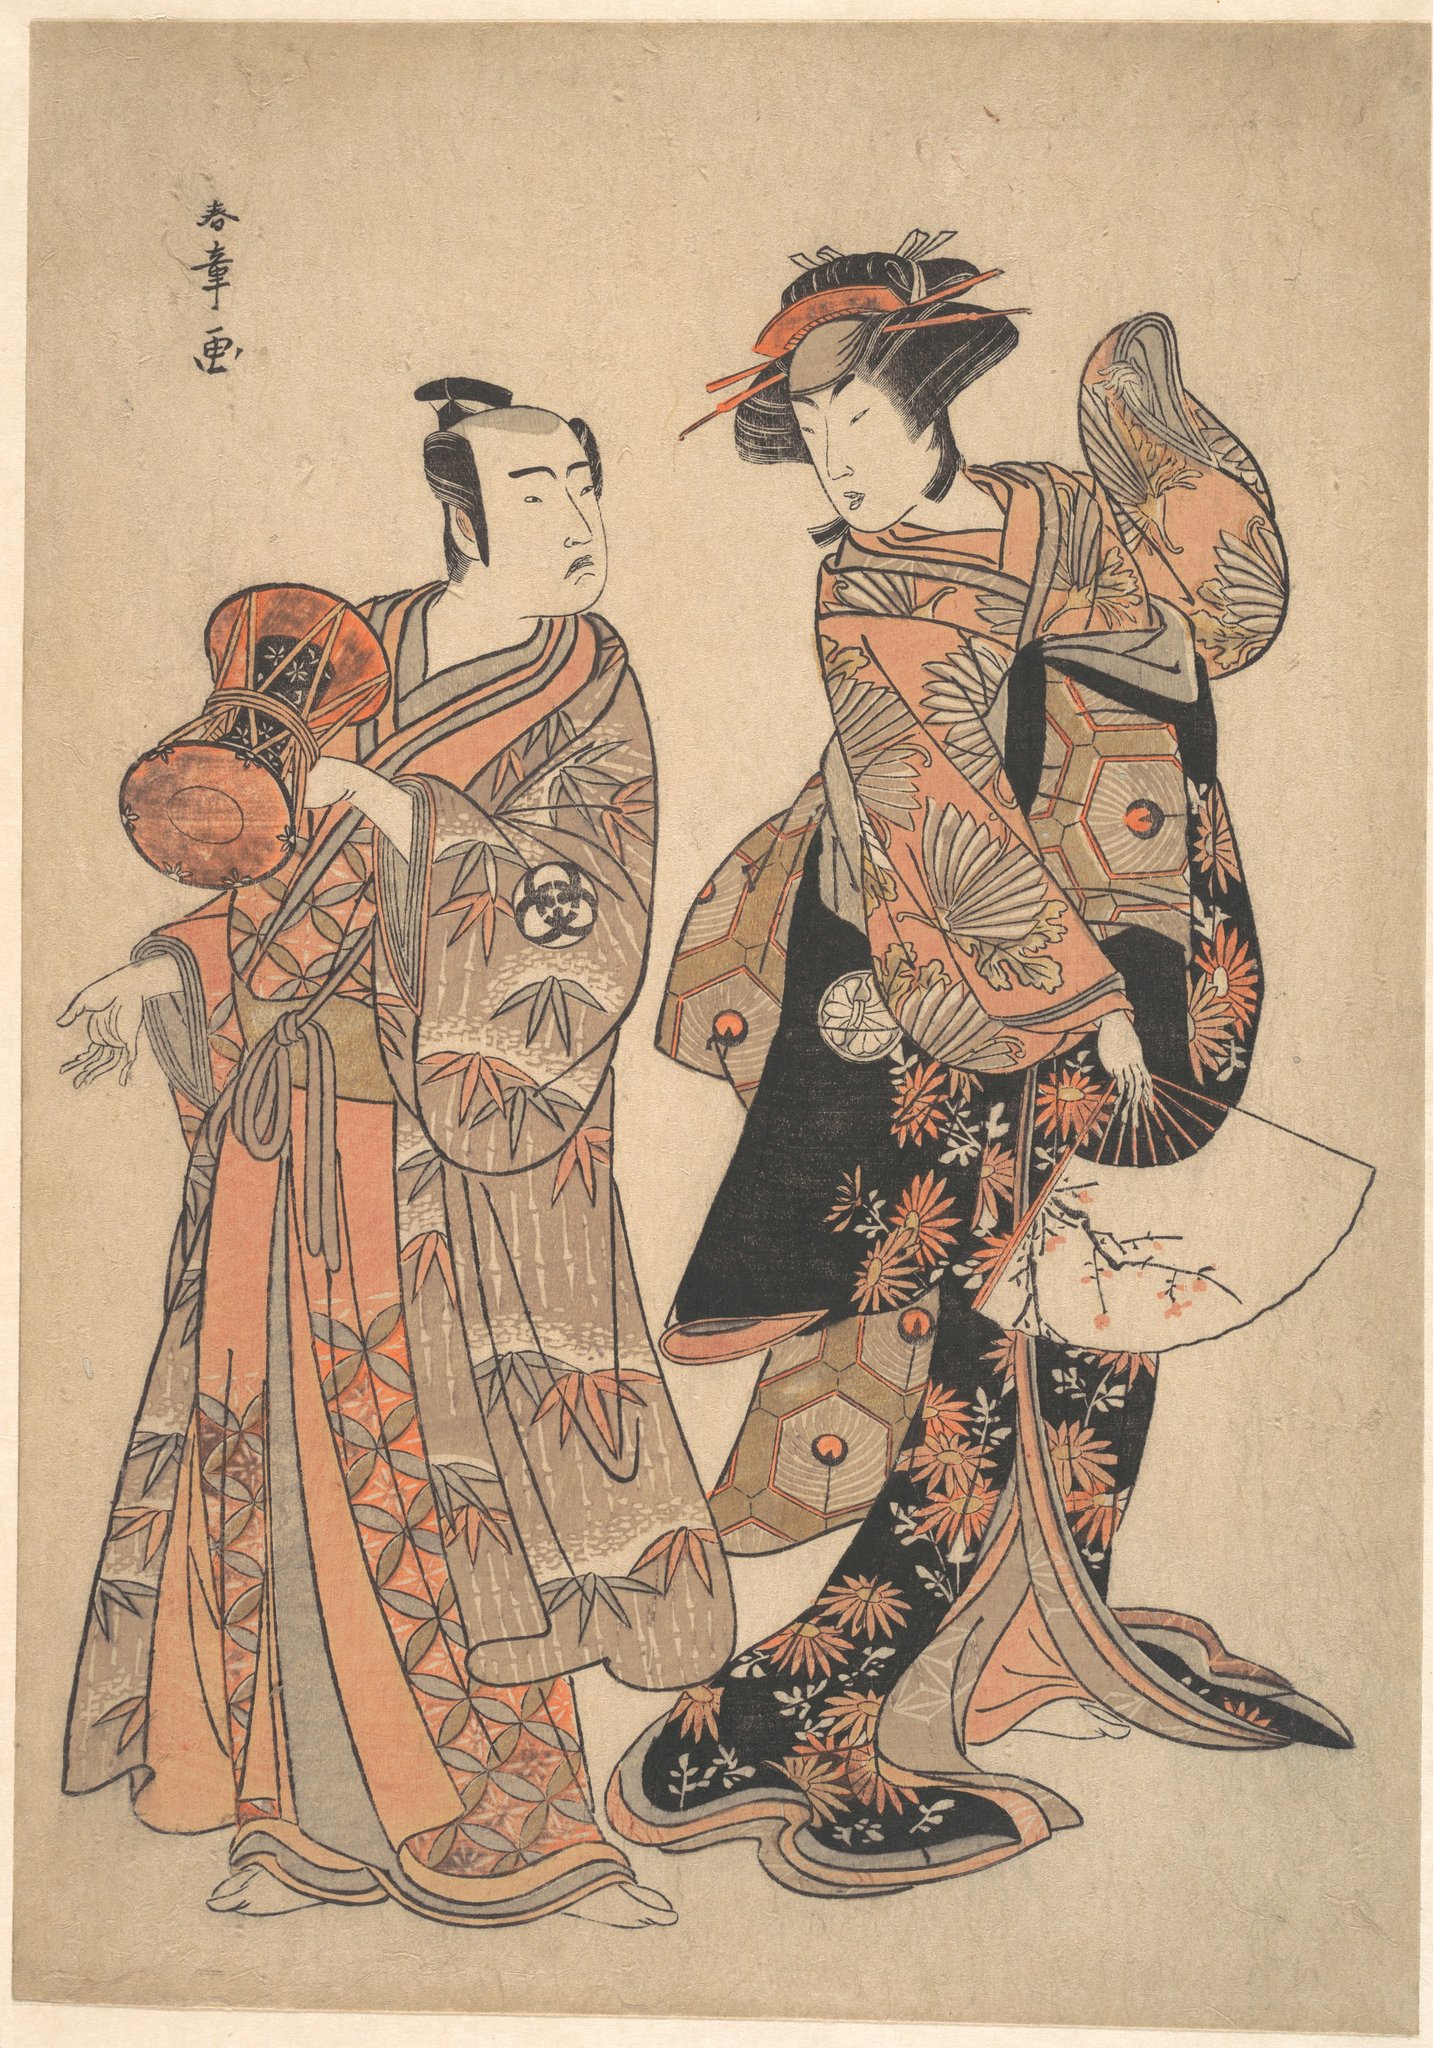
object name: woodblock print nishiki e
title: The Third Segawa Kikunojō as Ochiyo and Bando Mitsugorō as Hanbei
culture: japanese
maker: katsukawa shunshō 勝川春章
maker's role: artist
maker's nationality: japanese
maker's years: 1726-1792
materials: ink, paper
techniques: nishiki e, woodblock print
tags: musical instruments,fans,men,women,actors